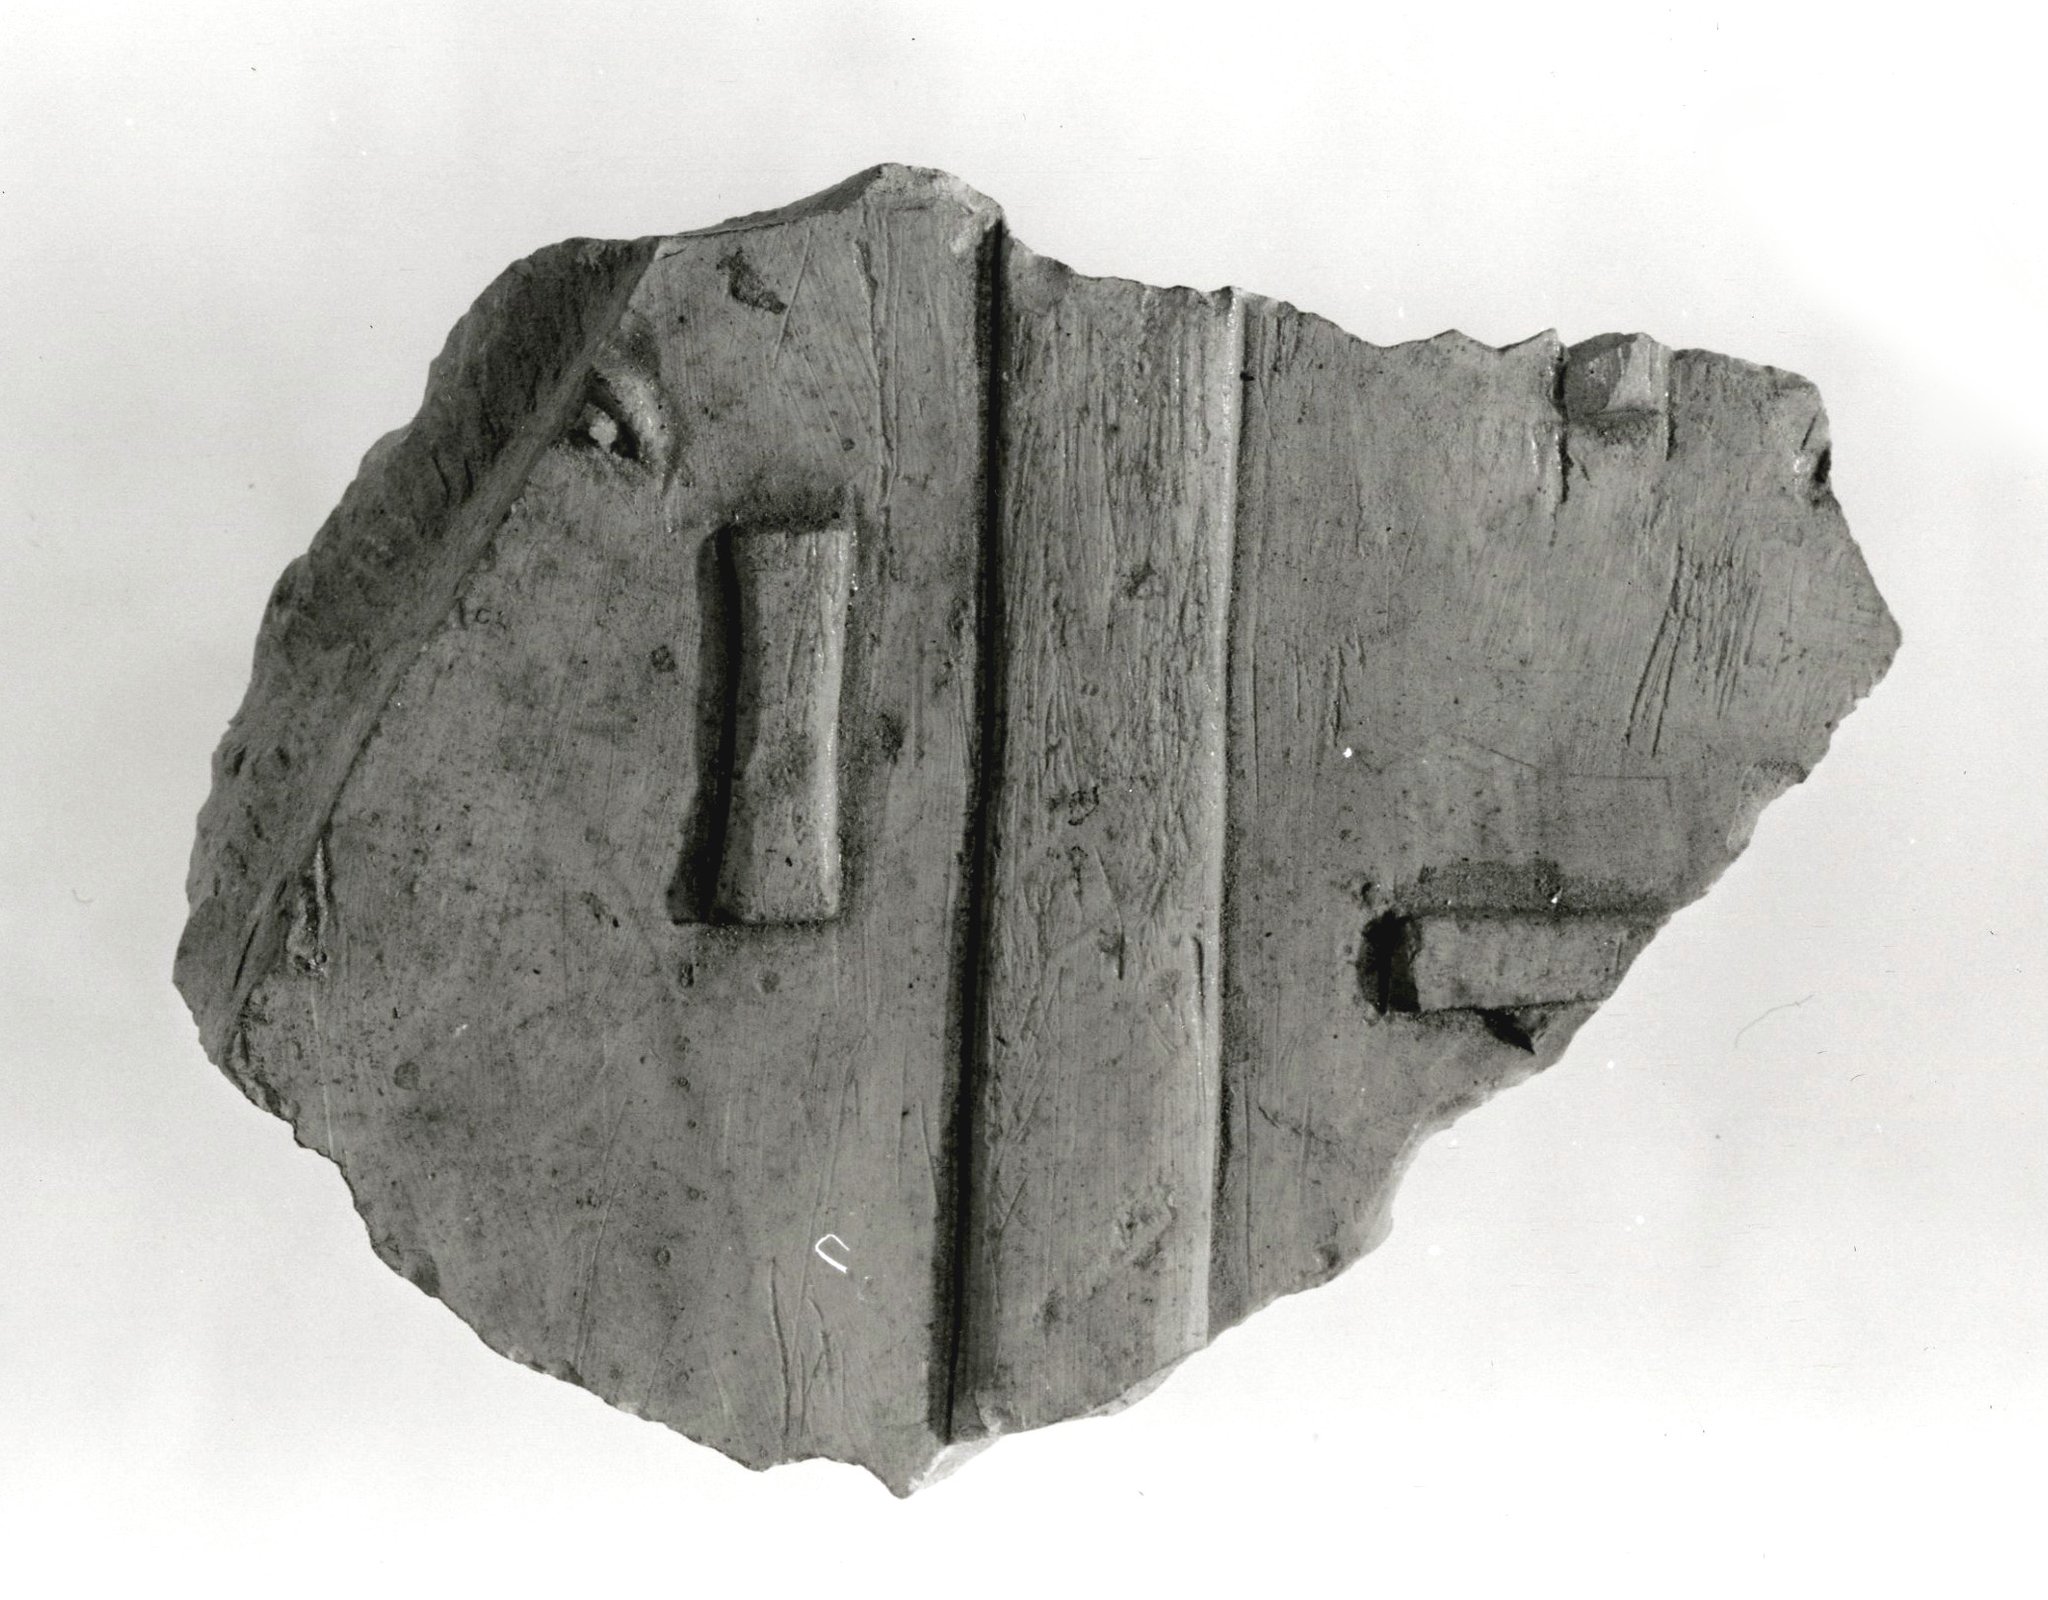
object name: relief, tomb of nespekashuty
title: Raised relief fragment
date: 664-610 BCE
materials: limestone, varnish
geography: egypt